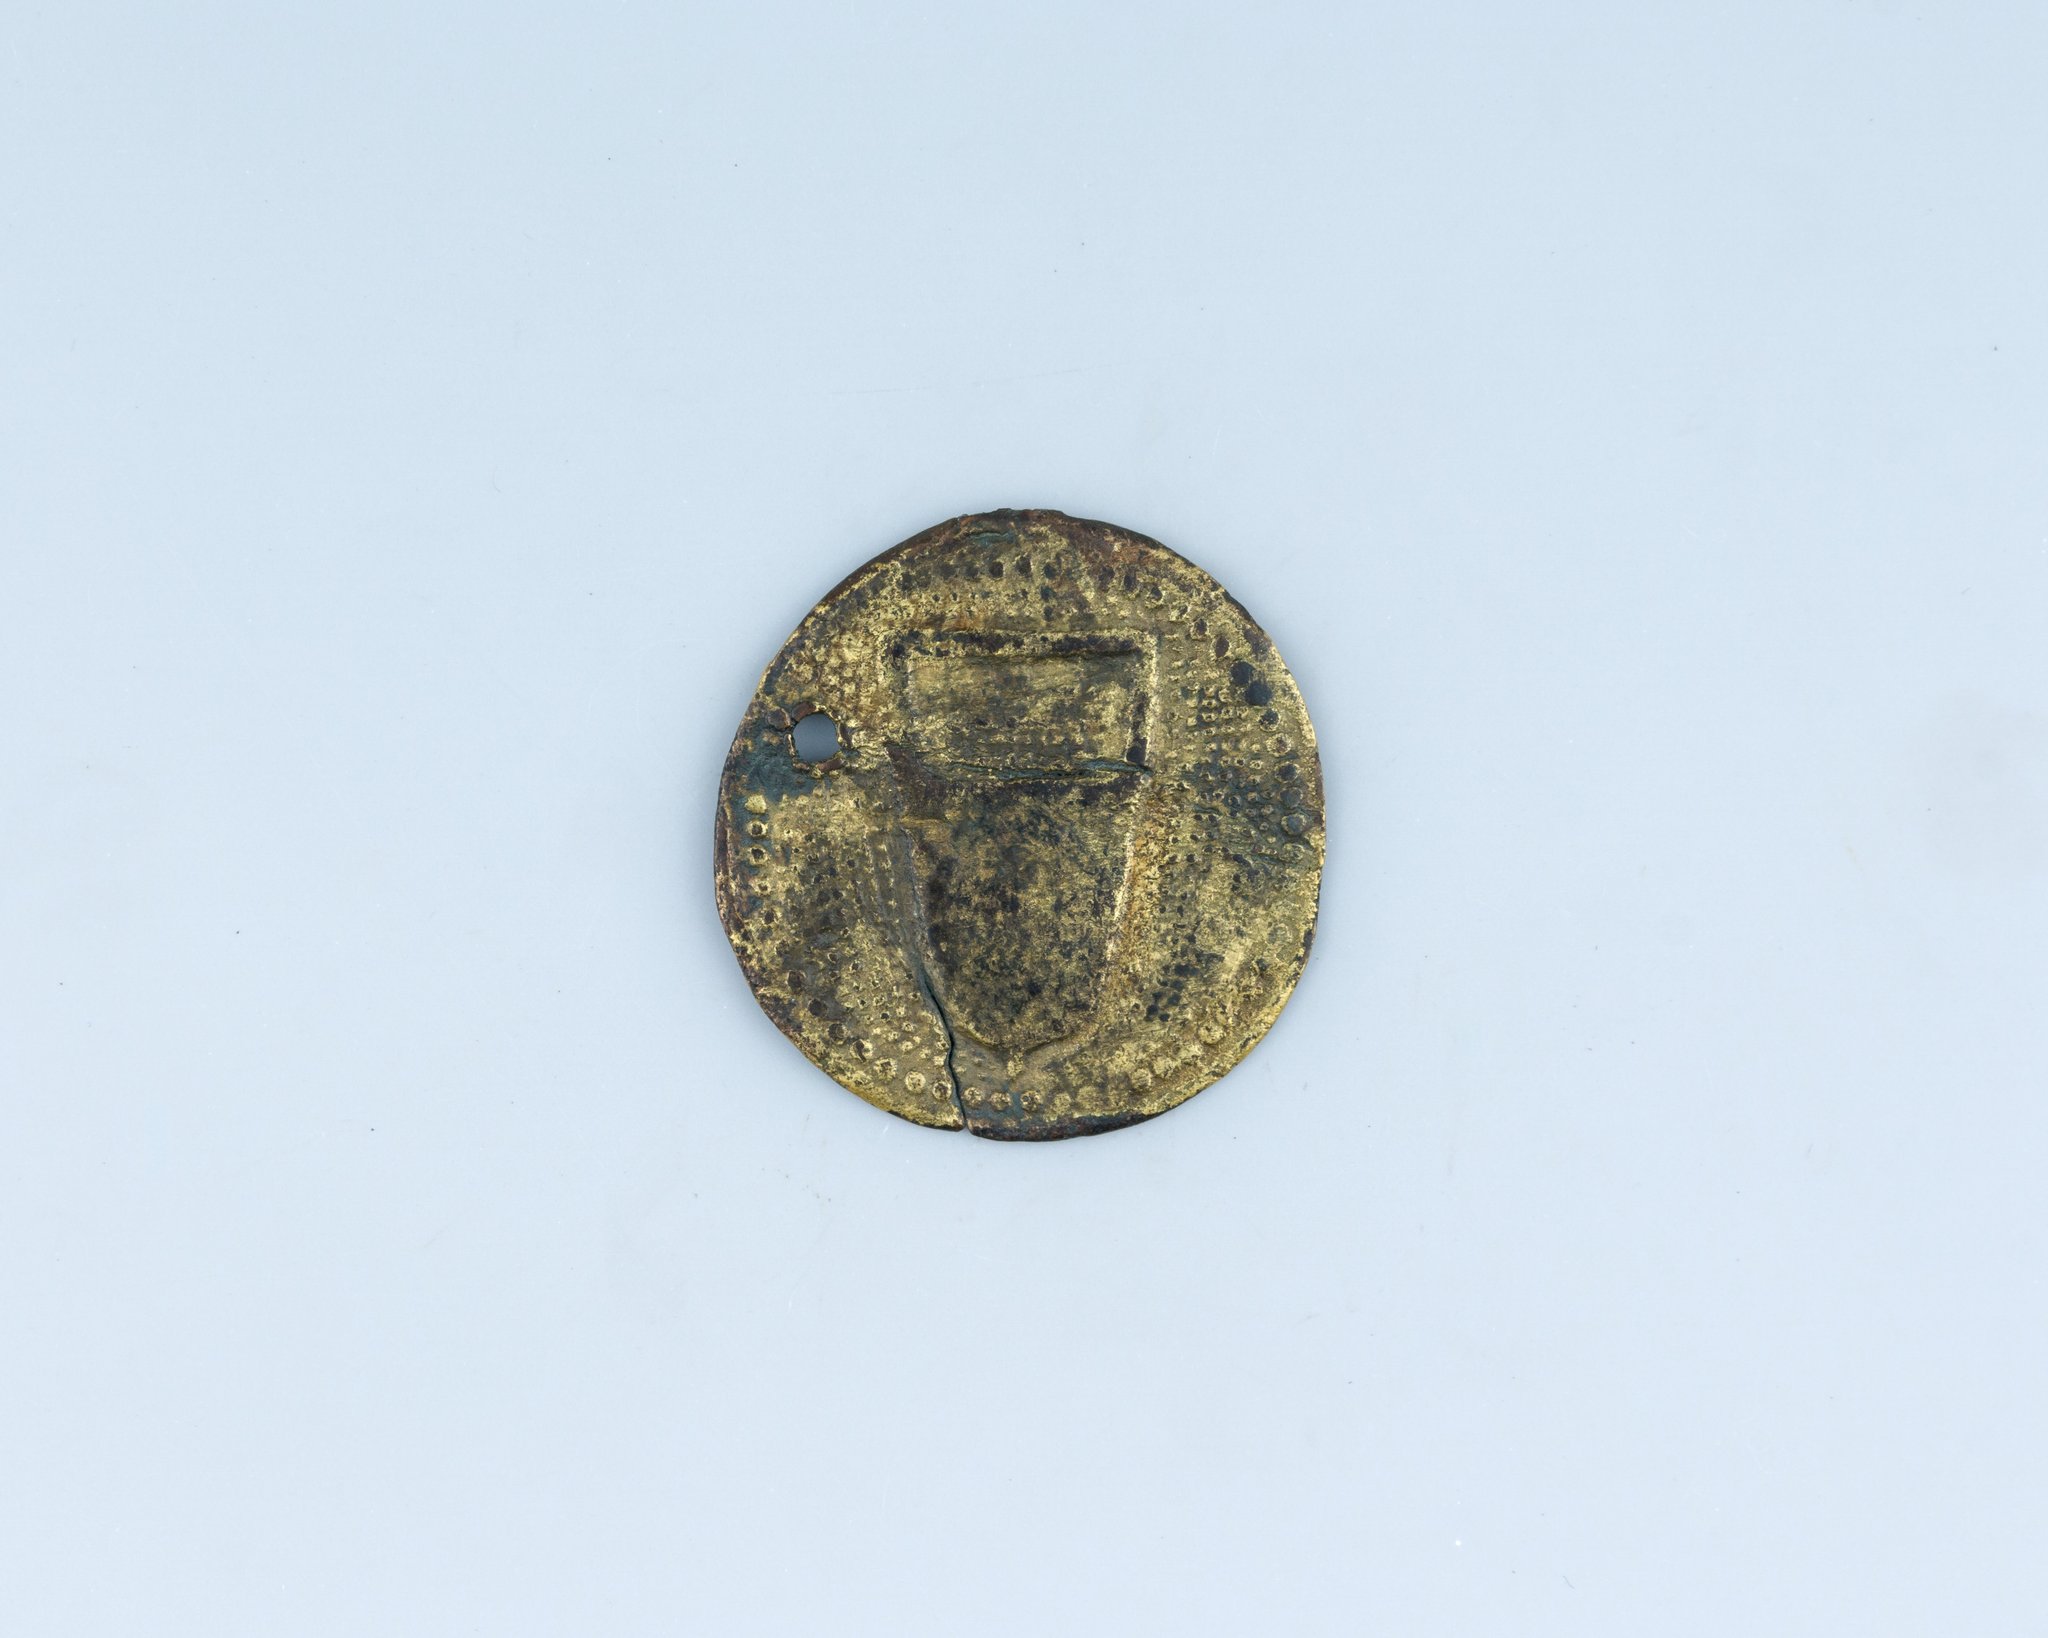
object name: pendant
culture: european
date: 1401-1700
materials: bronze, gilt